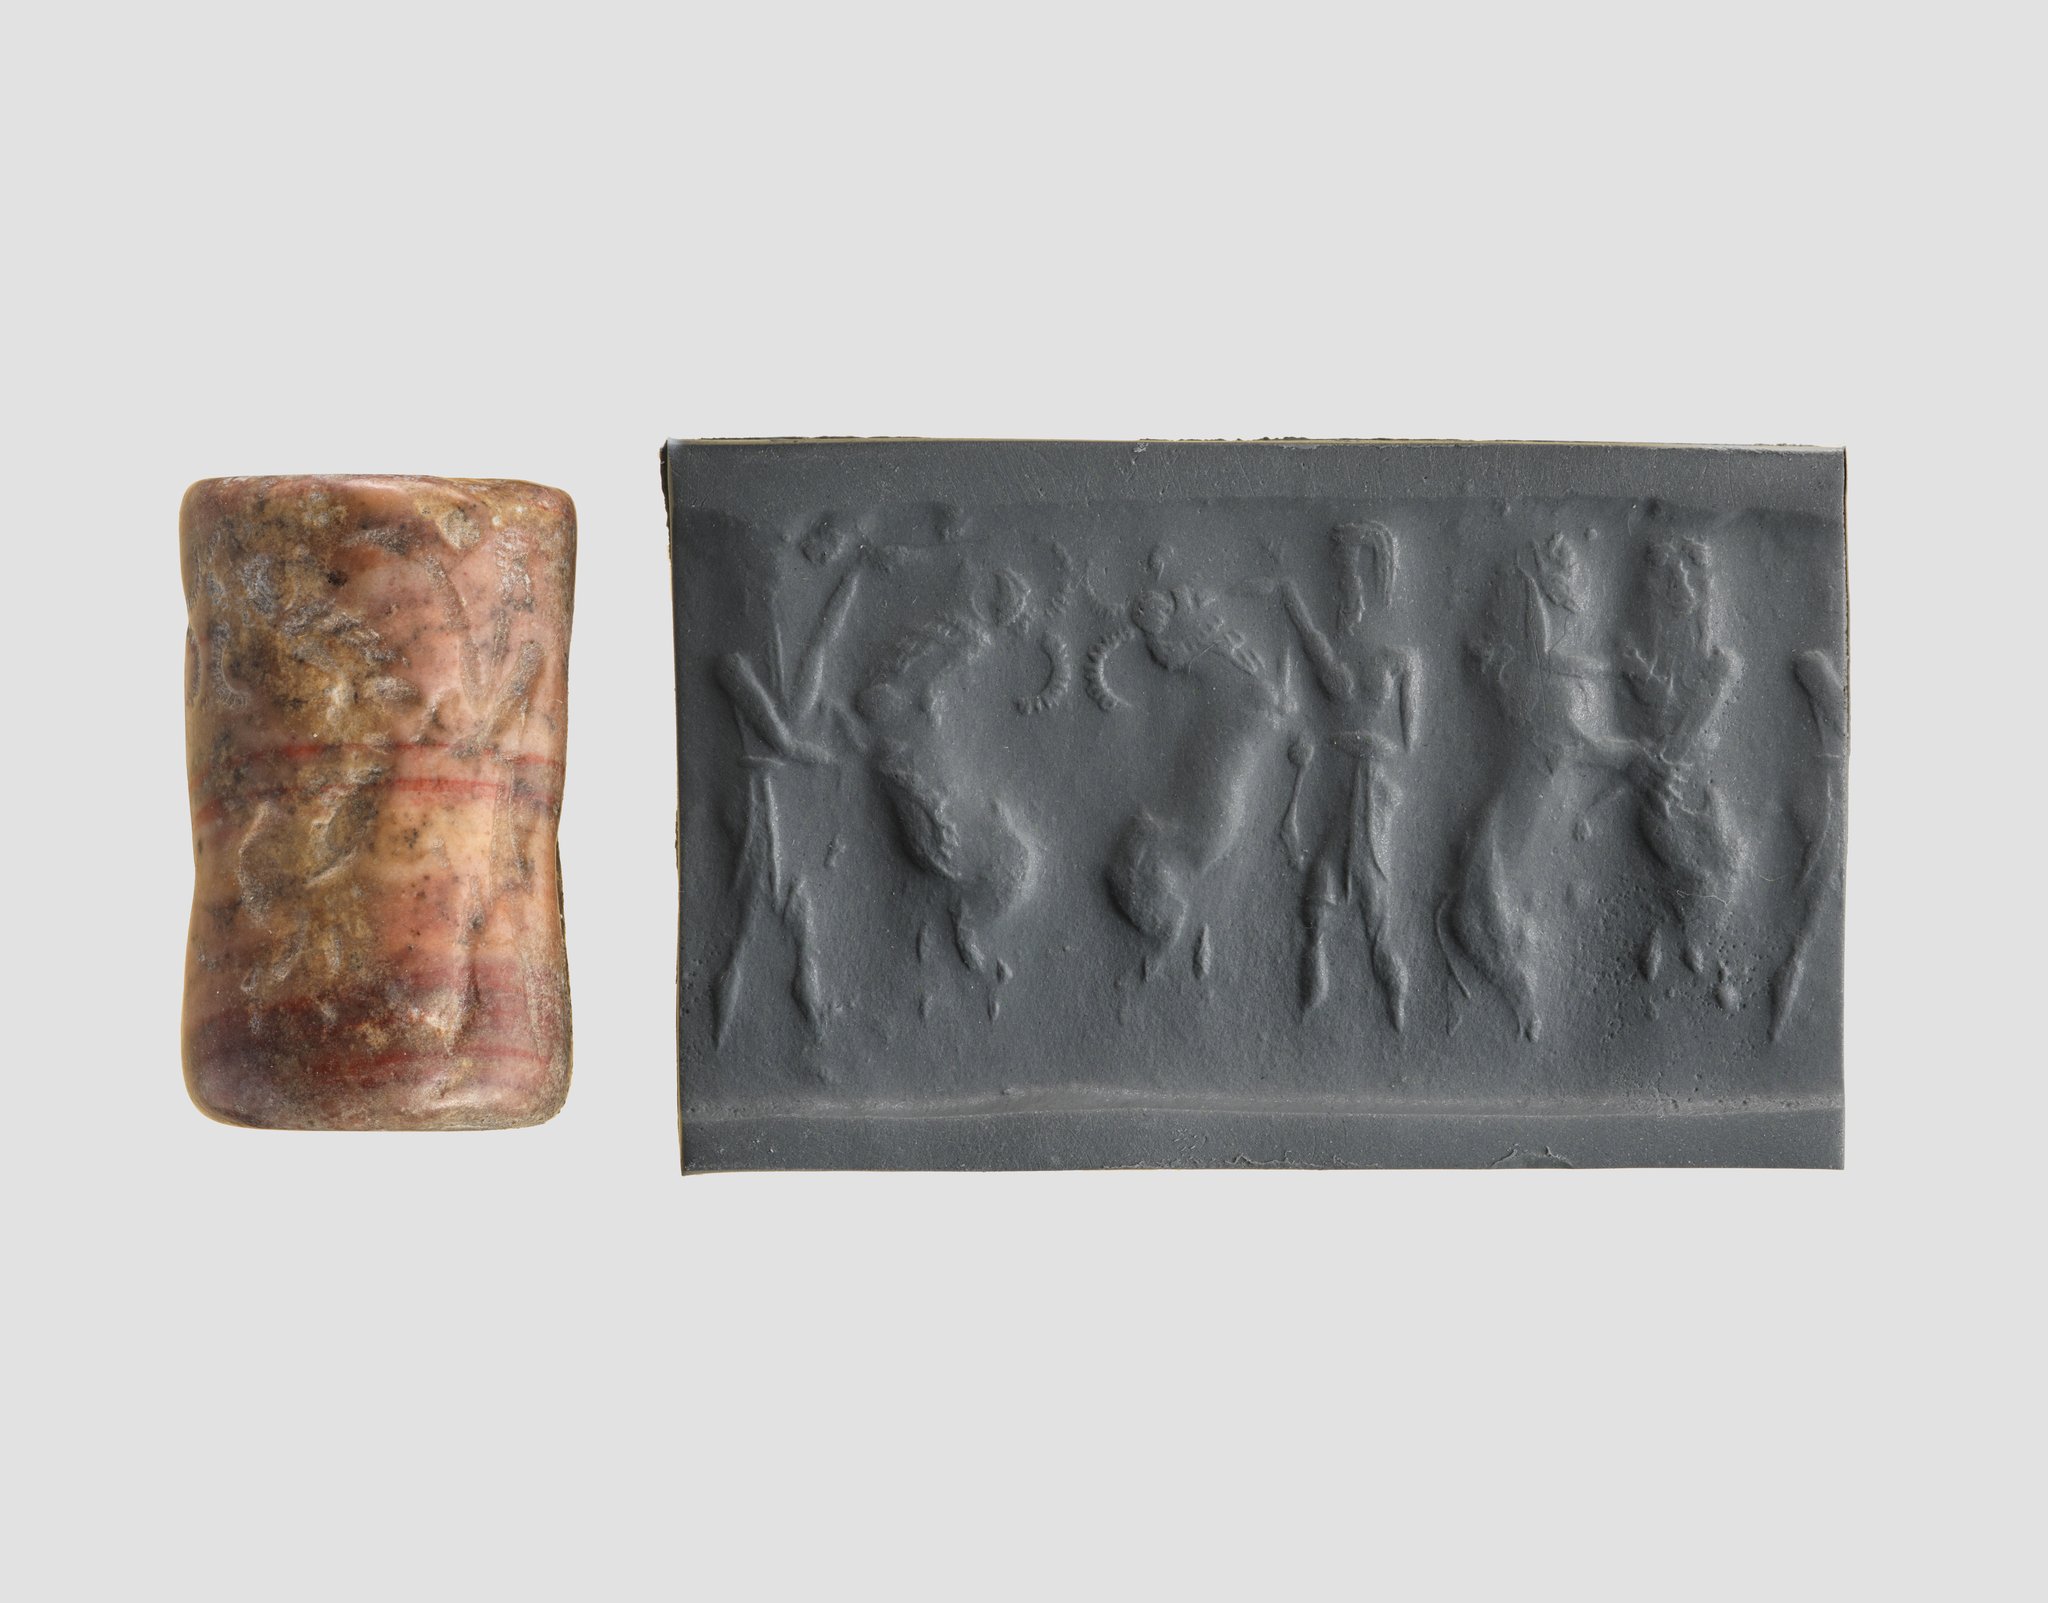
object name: cylinder seal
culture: akkadian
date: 2350-2150 BCE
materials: marble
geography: mesopotamia